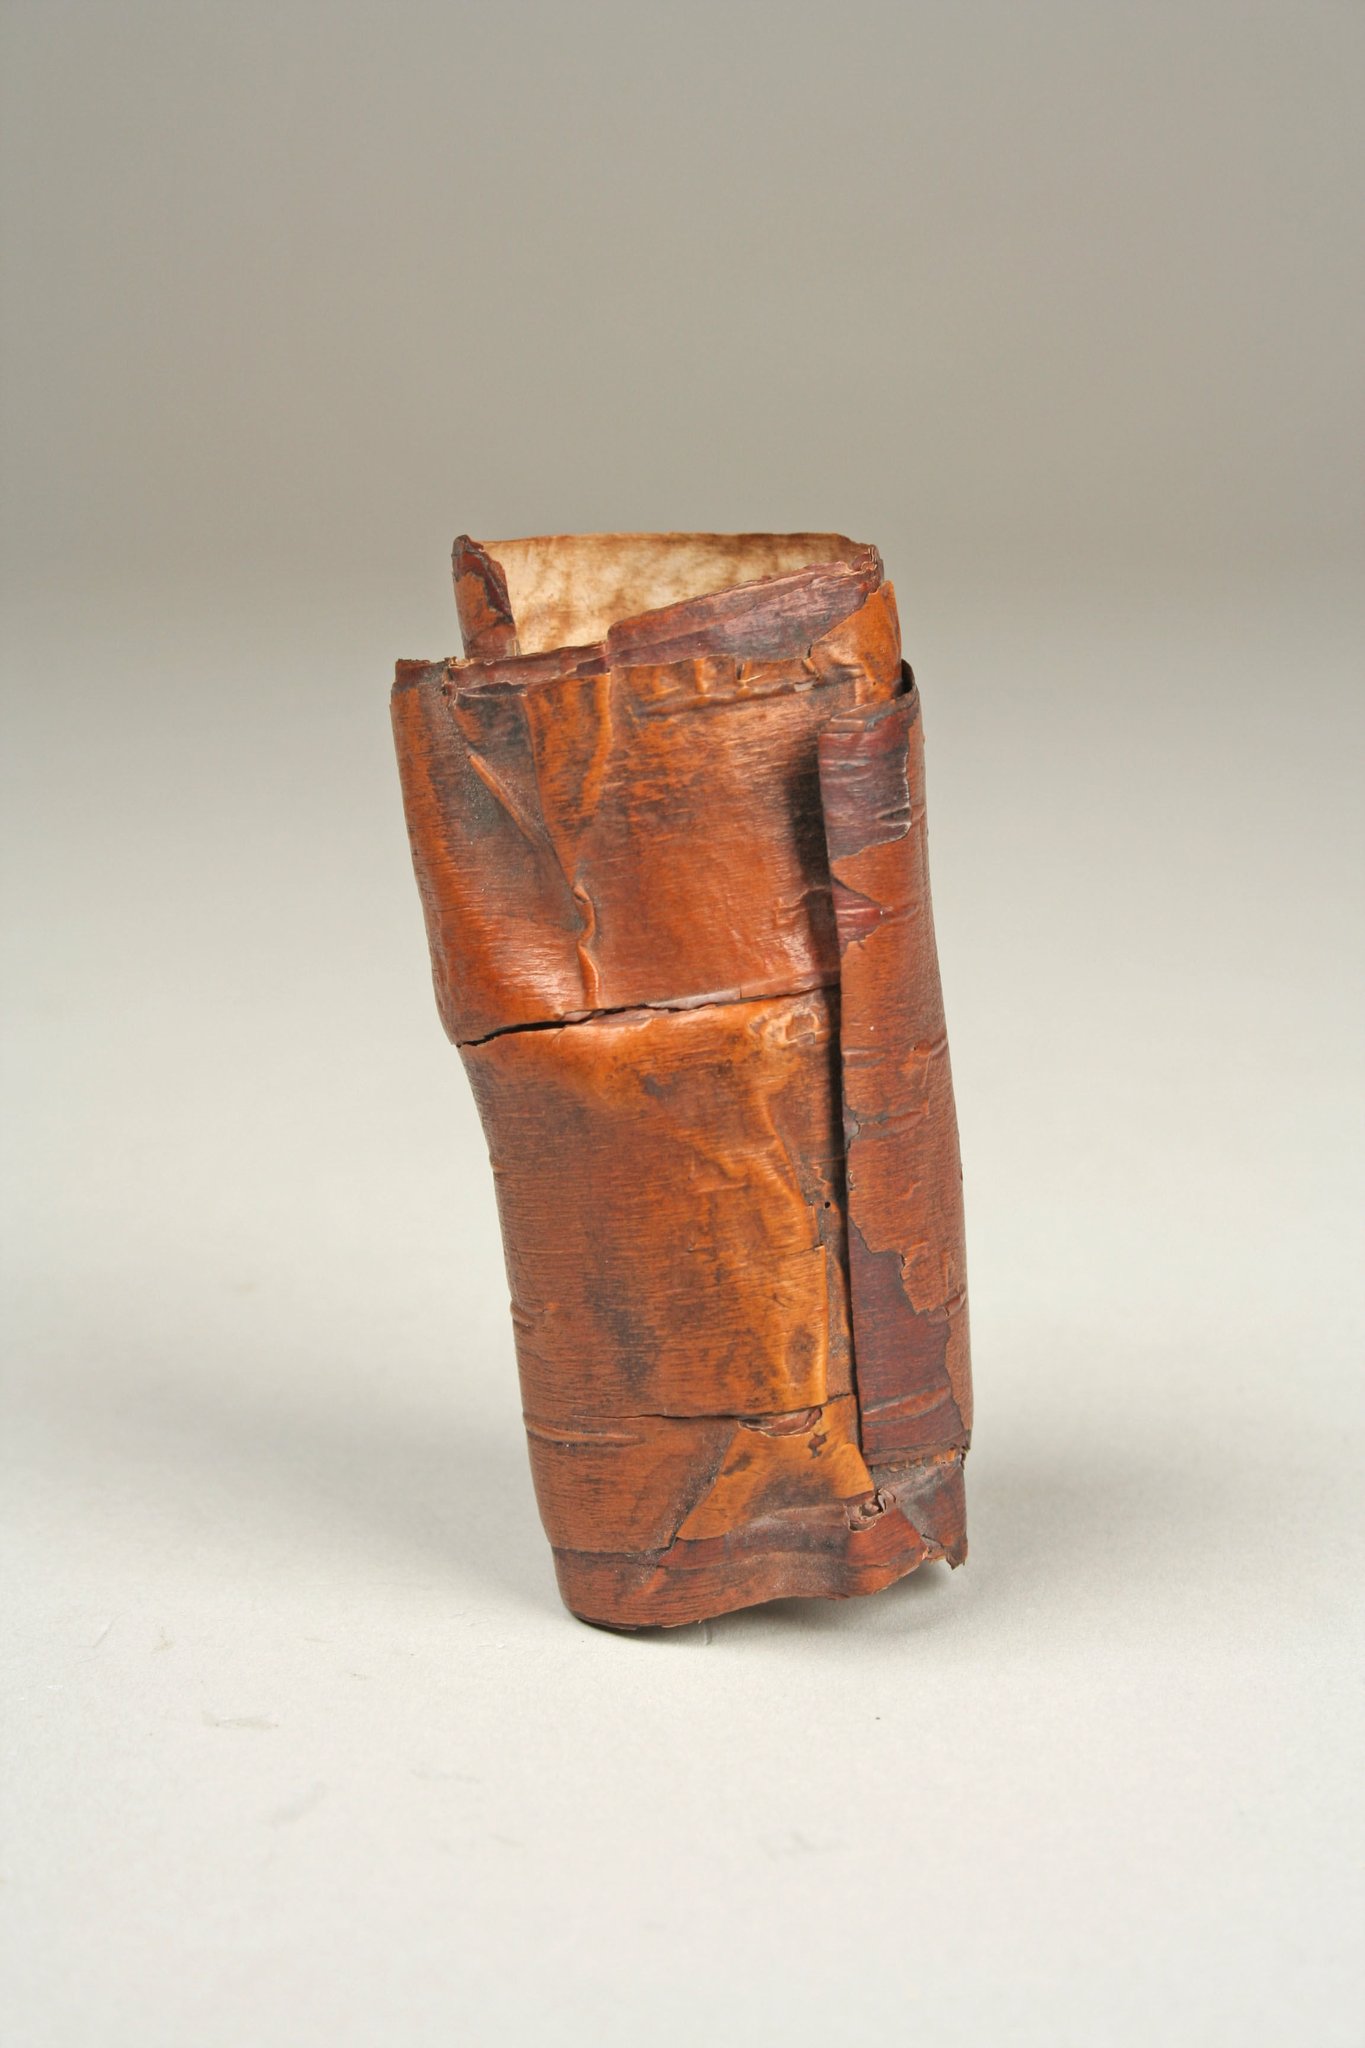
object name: doll wrapper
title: Doll's Wrapper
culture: mesquakie or potawatomi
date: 1790-1890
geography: united states